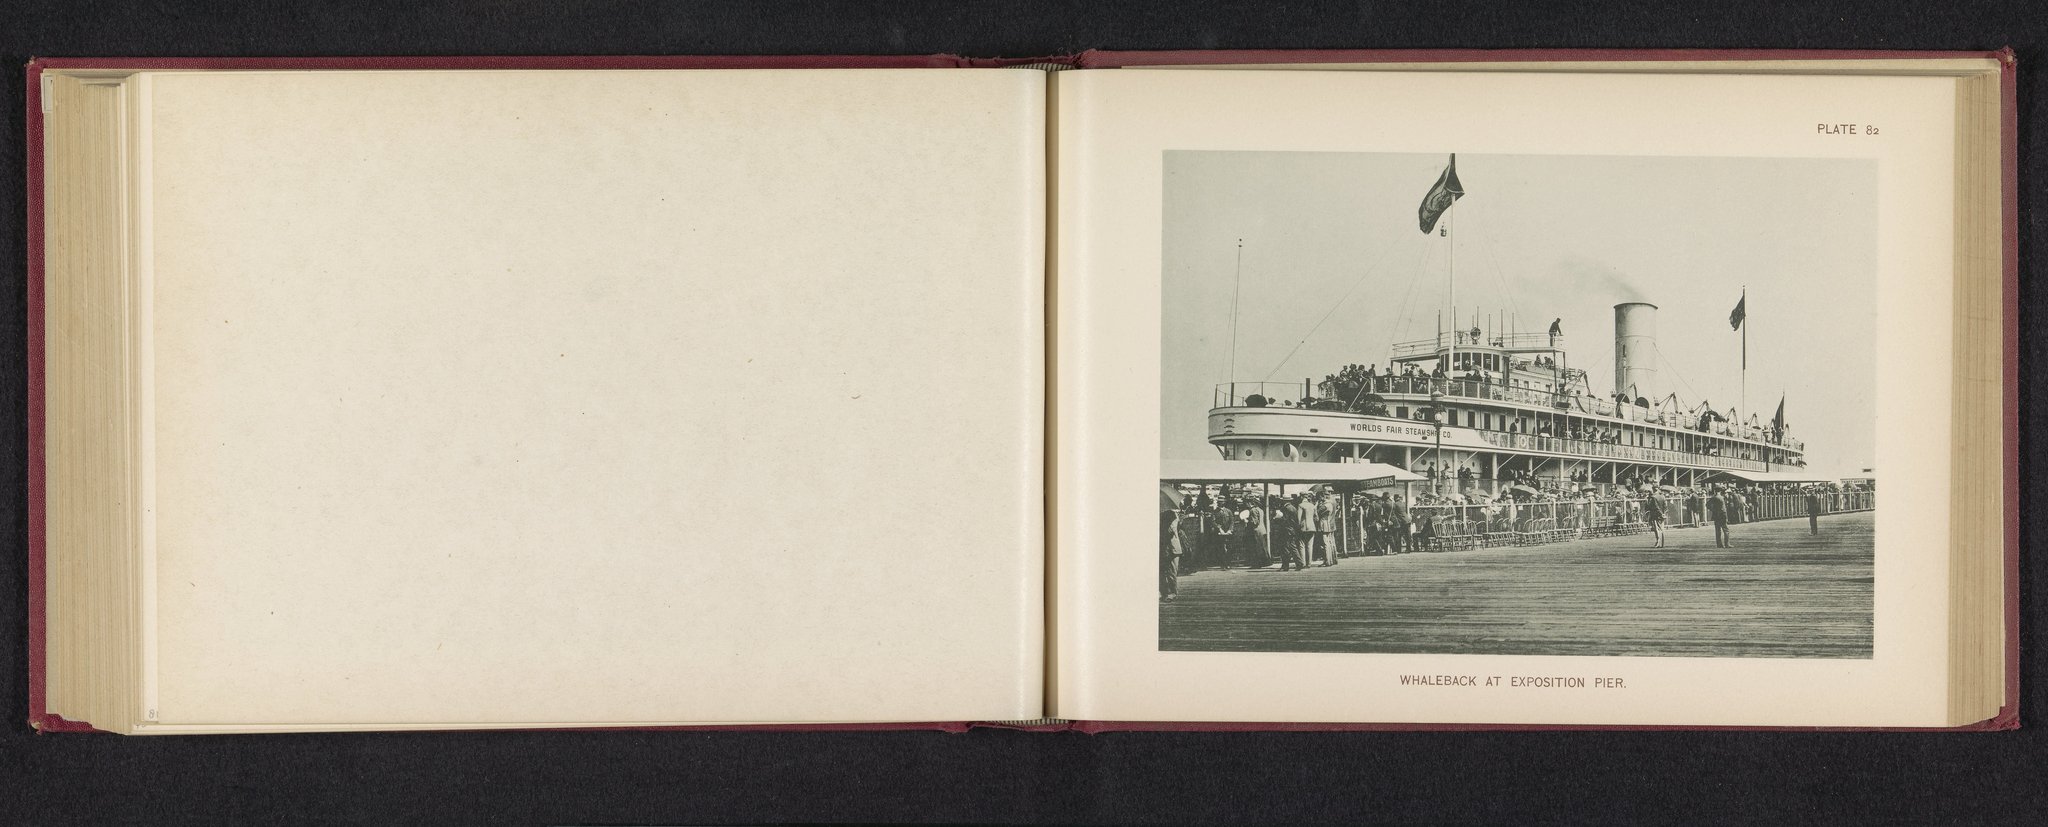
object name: page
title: Whaleback at exposition pier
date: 1893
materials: paper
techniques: photograph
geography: chicago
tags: world fair, world exhibition, ships (in general), pier, quay, wharf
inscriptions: number: ‘Plate 82’